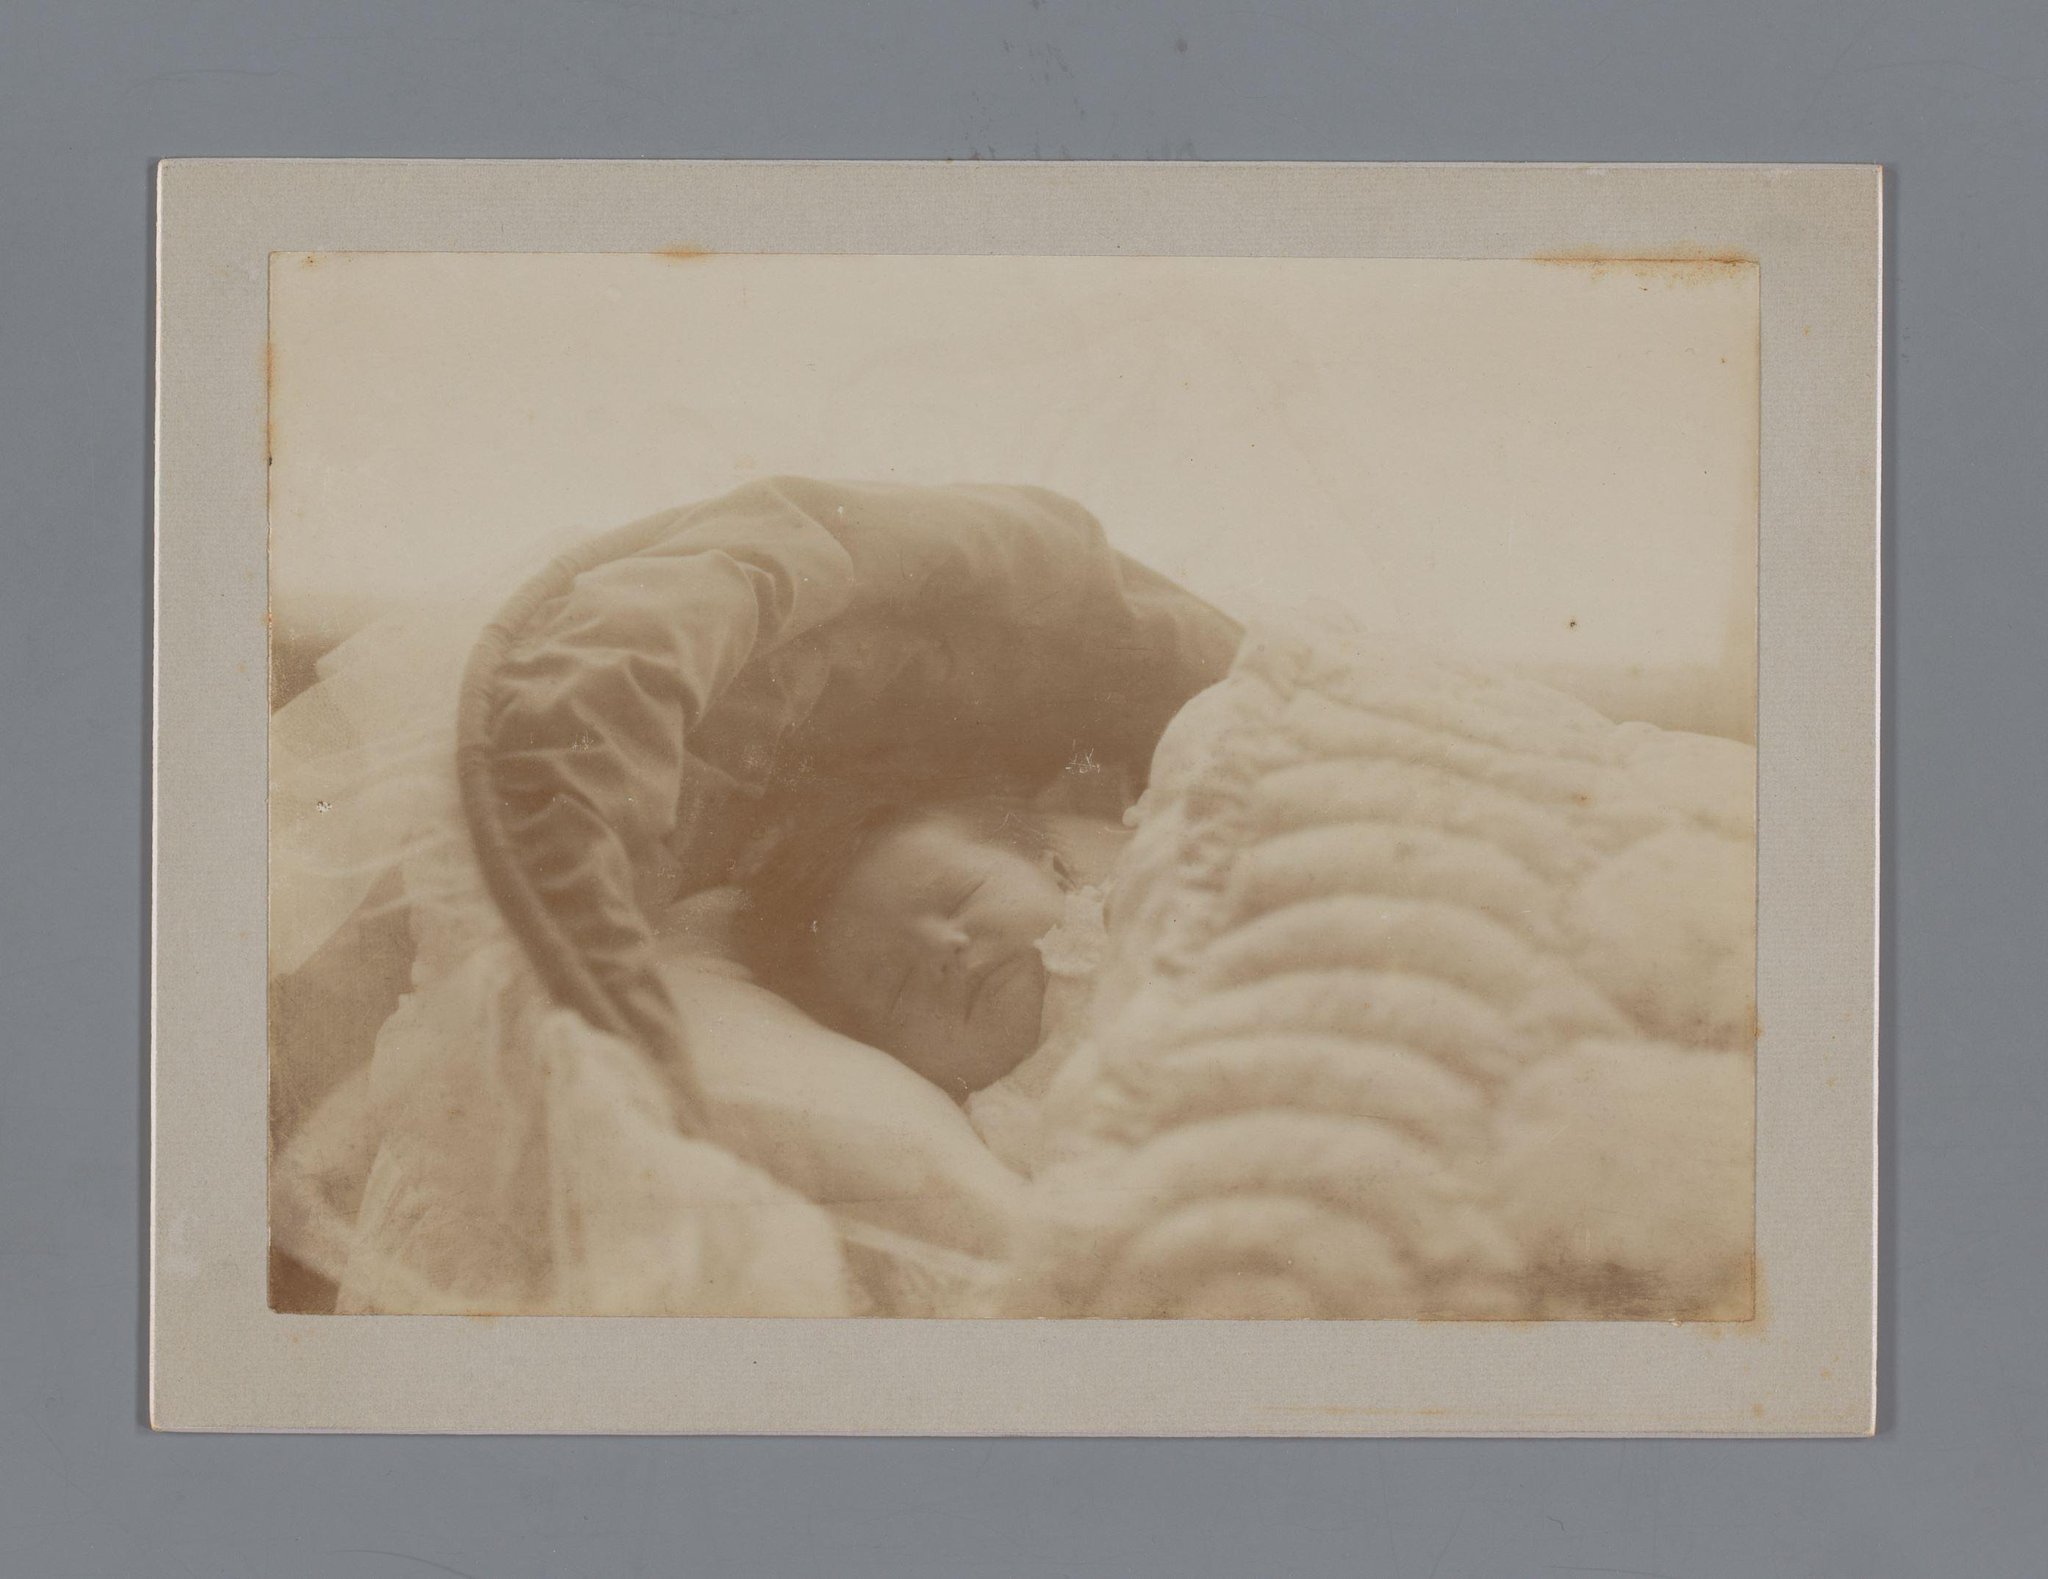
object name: photograph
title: Portret van Johanna Geertruida van der Waals slapend in de wieg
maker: johannes diderik van der waals (1873-1971)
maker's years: 1873-1971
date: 1903-1905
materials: cardboard, photographic support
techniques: collodion silver print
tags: historical persons, cradle, crib, infant, baby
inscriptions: annotation: ‘?’